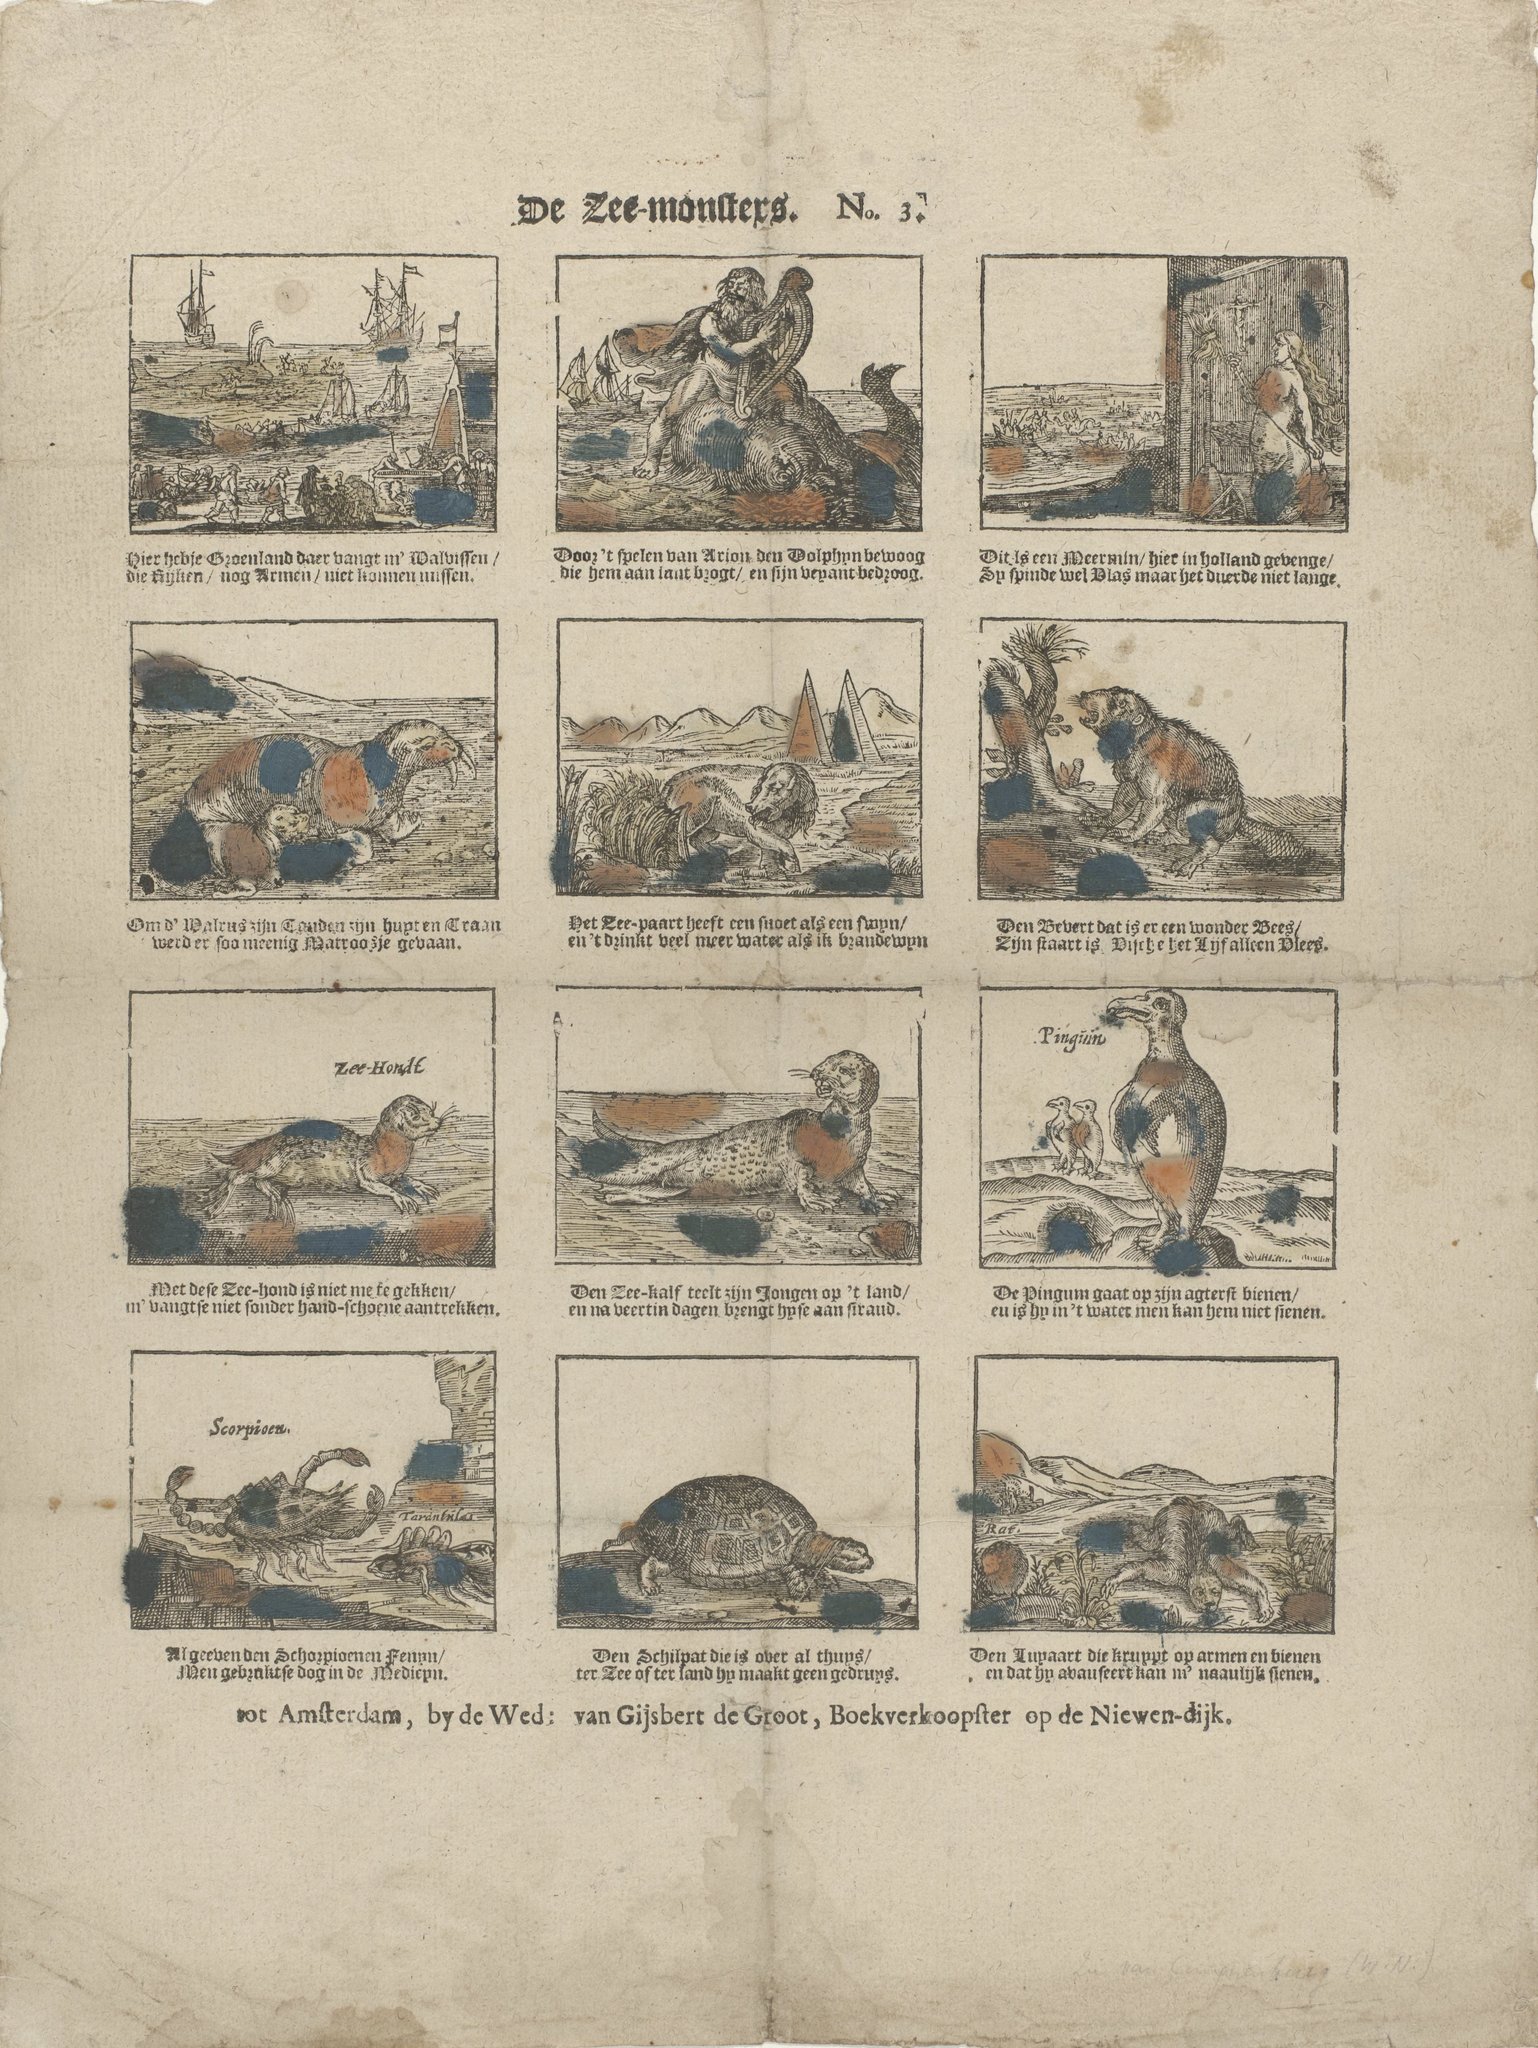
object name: print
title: De zee-monsters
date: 1692-1717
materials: paper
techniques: colour, letterpress printing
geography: amsterdam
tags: tortoises, turtles, water-birds: penguin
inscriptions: collector's mark: Lugt 2228, collector's mark: Lugt 2760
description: Blad met 12 voorstellingen van dieren uit de zee, zoals een zeeleeuw, een pinguin en een schildpad. Onder elke afbeelding een tweeregelig vers. Genummerd midden boven: No. 3.